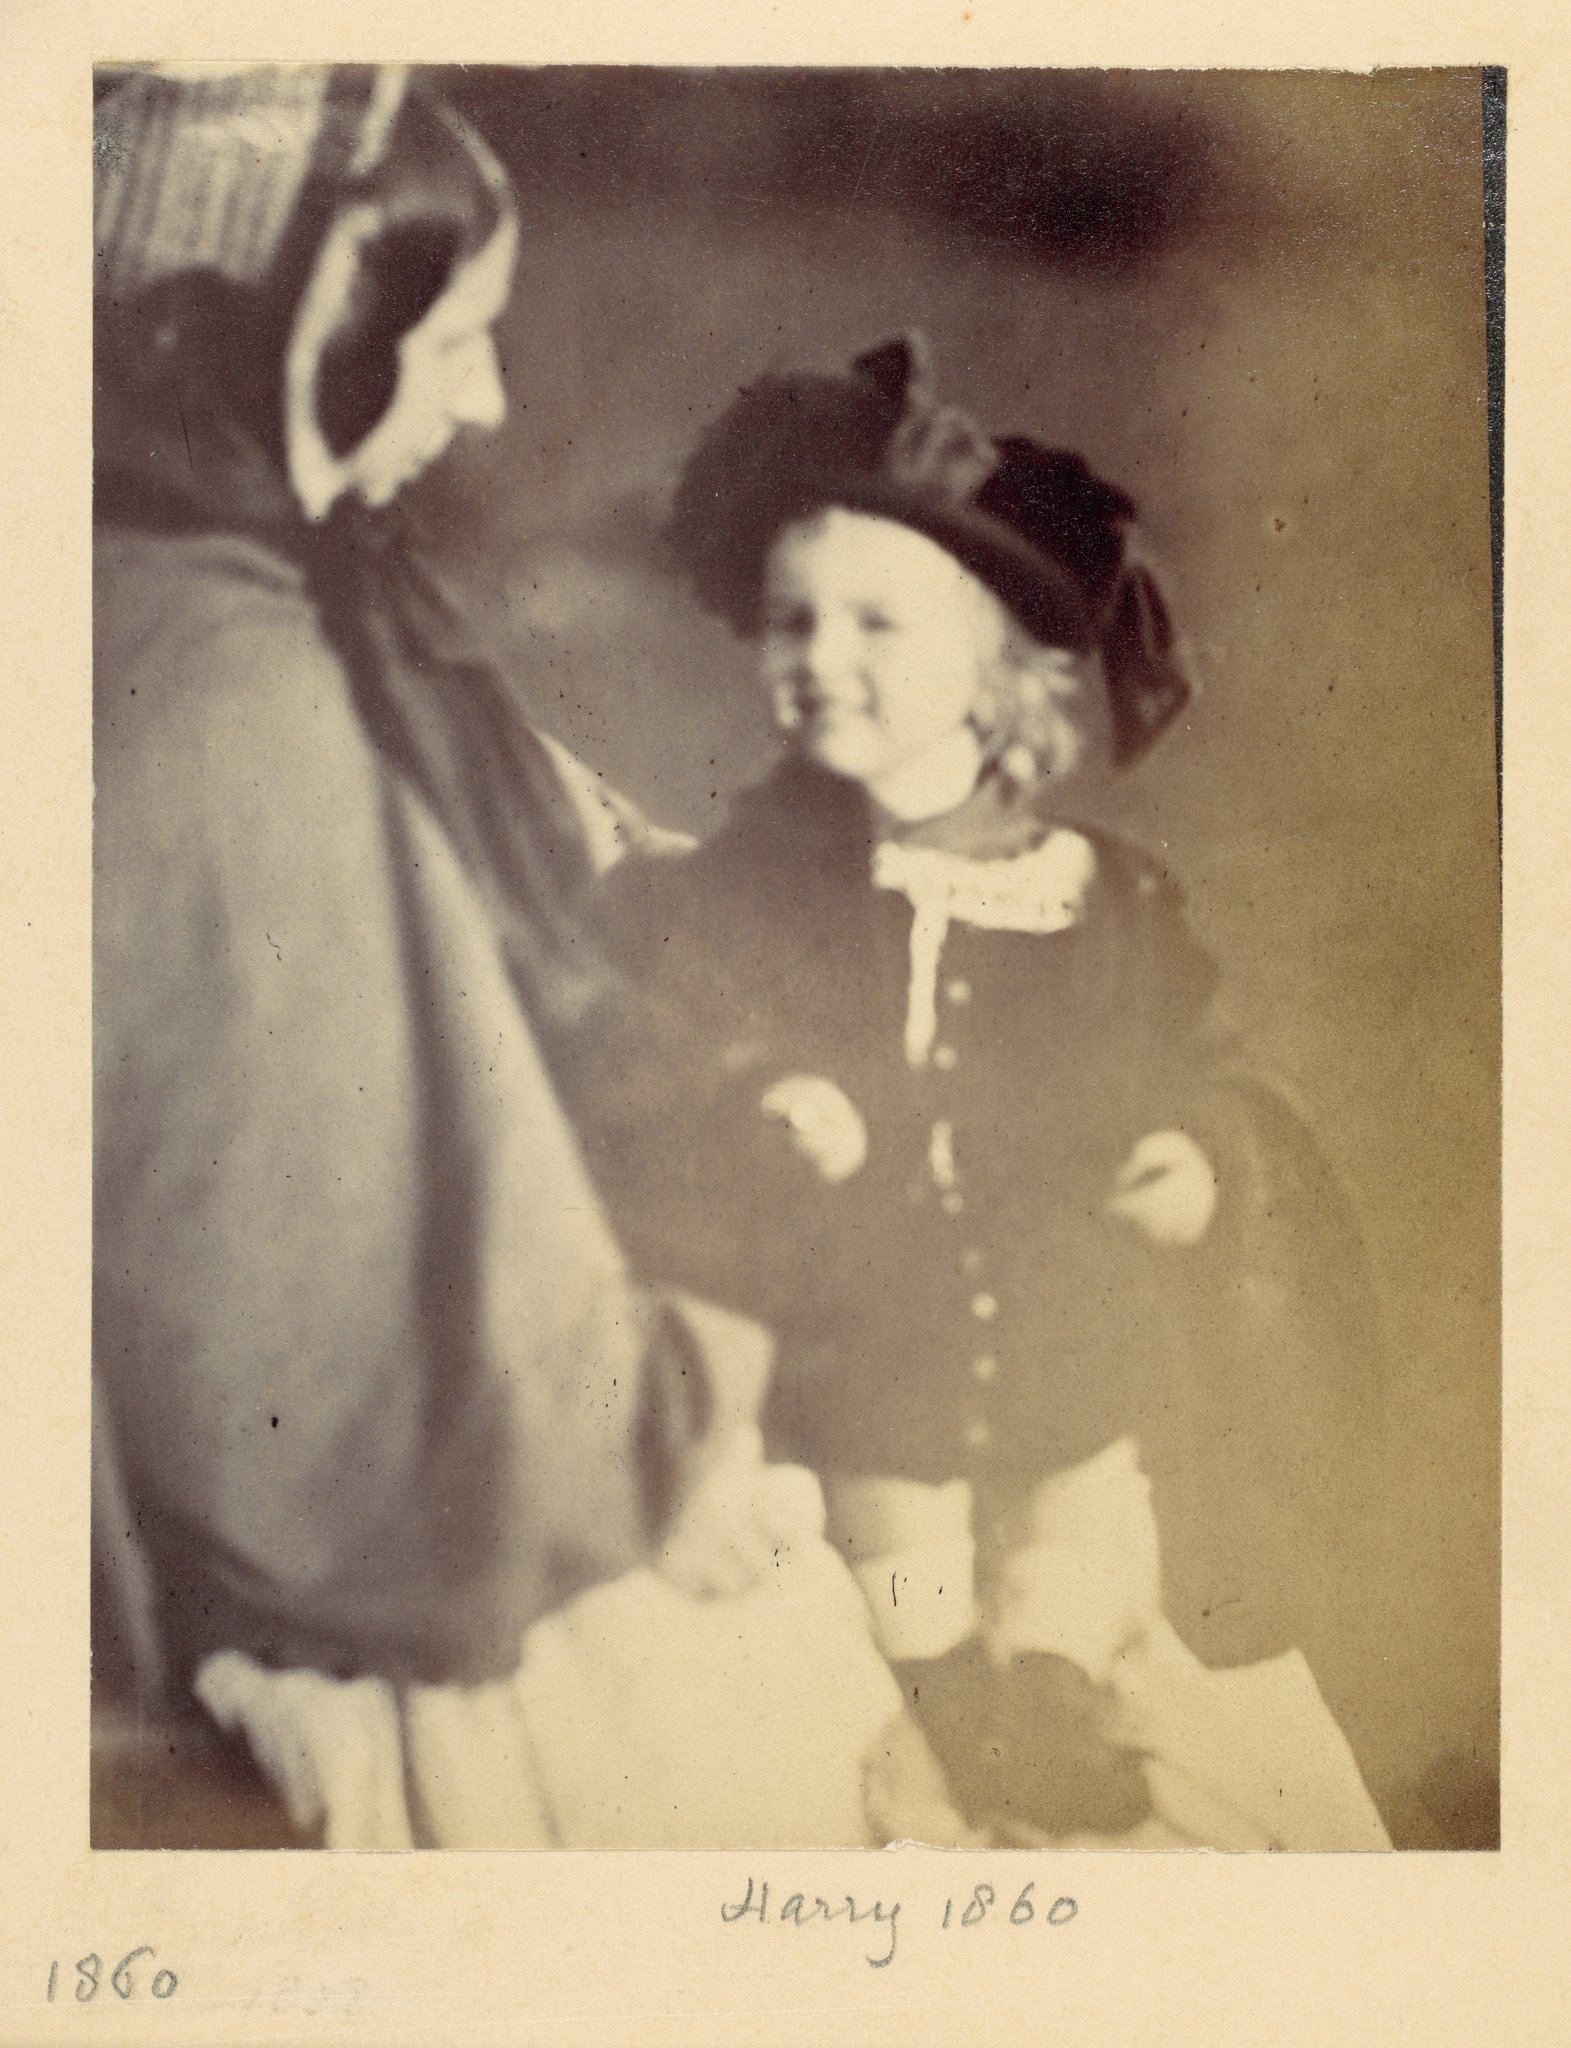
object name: photograph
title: Harry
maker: alfred capel cure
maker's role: artist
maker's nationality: british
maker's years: 1826-1896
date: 1860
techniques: albumen silver print, paper negative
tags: children,portraits,women